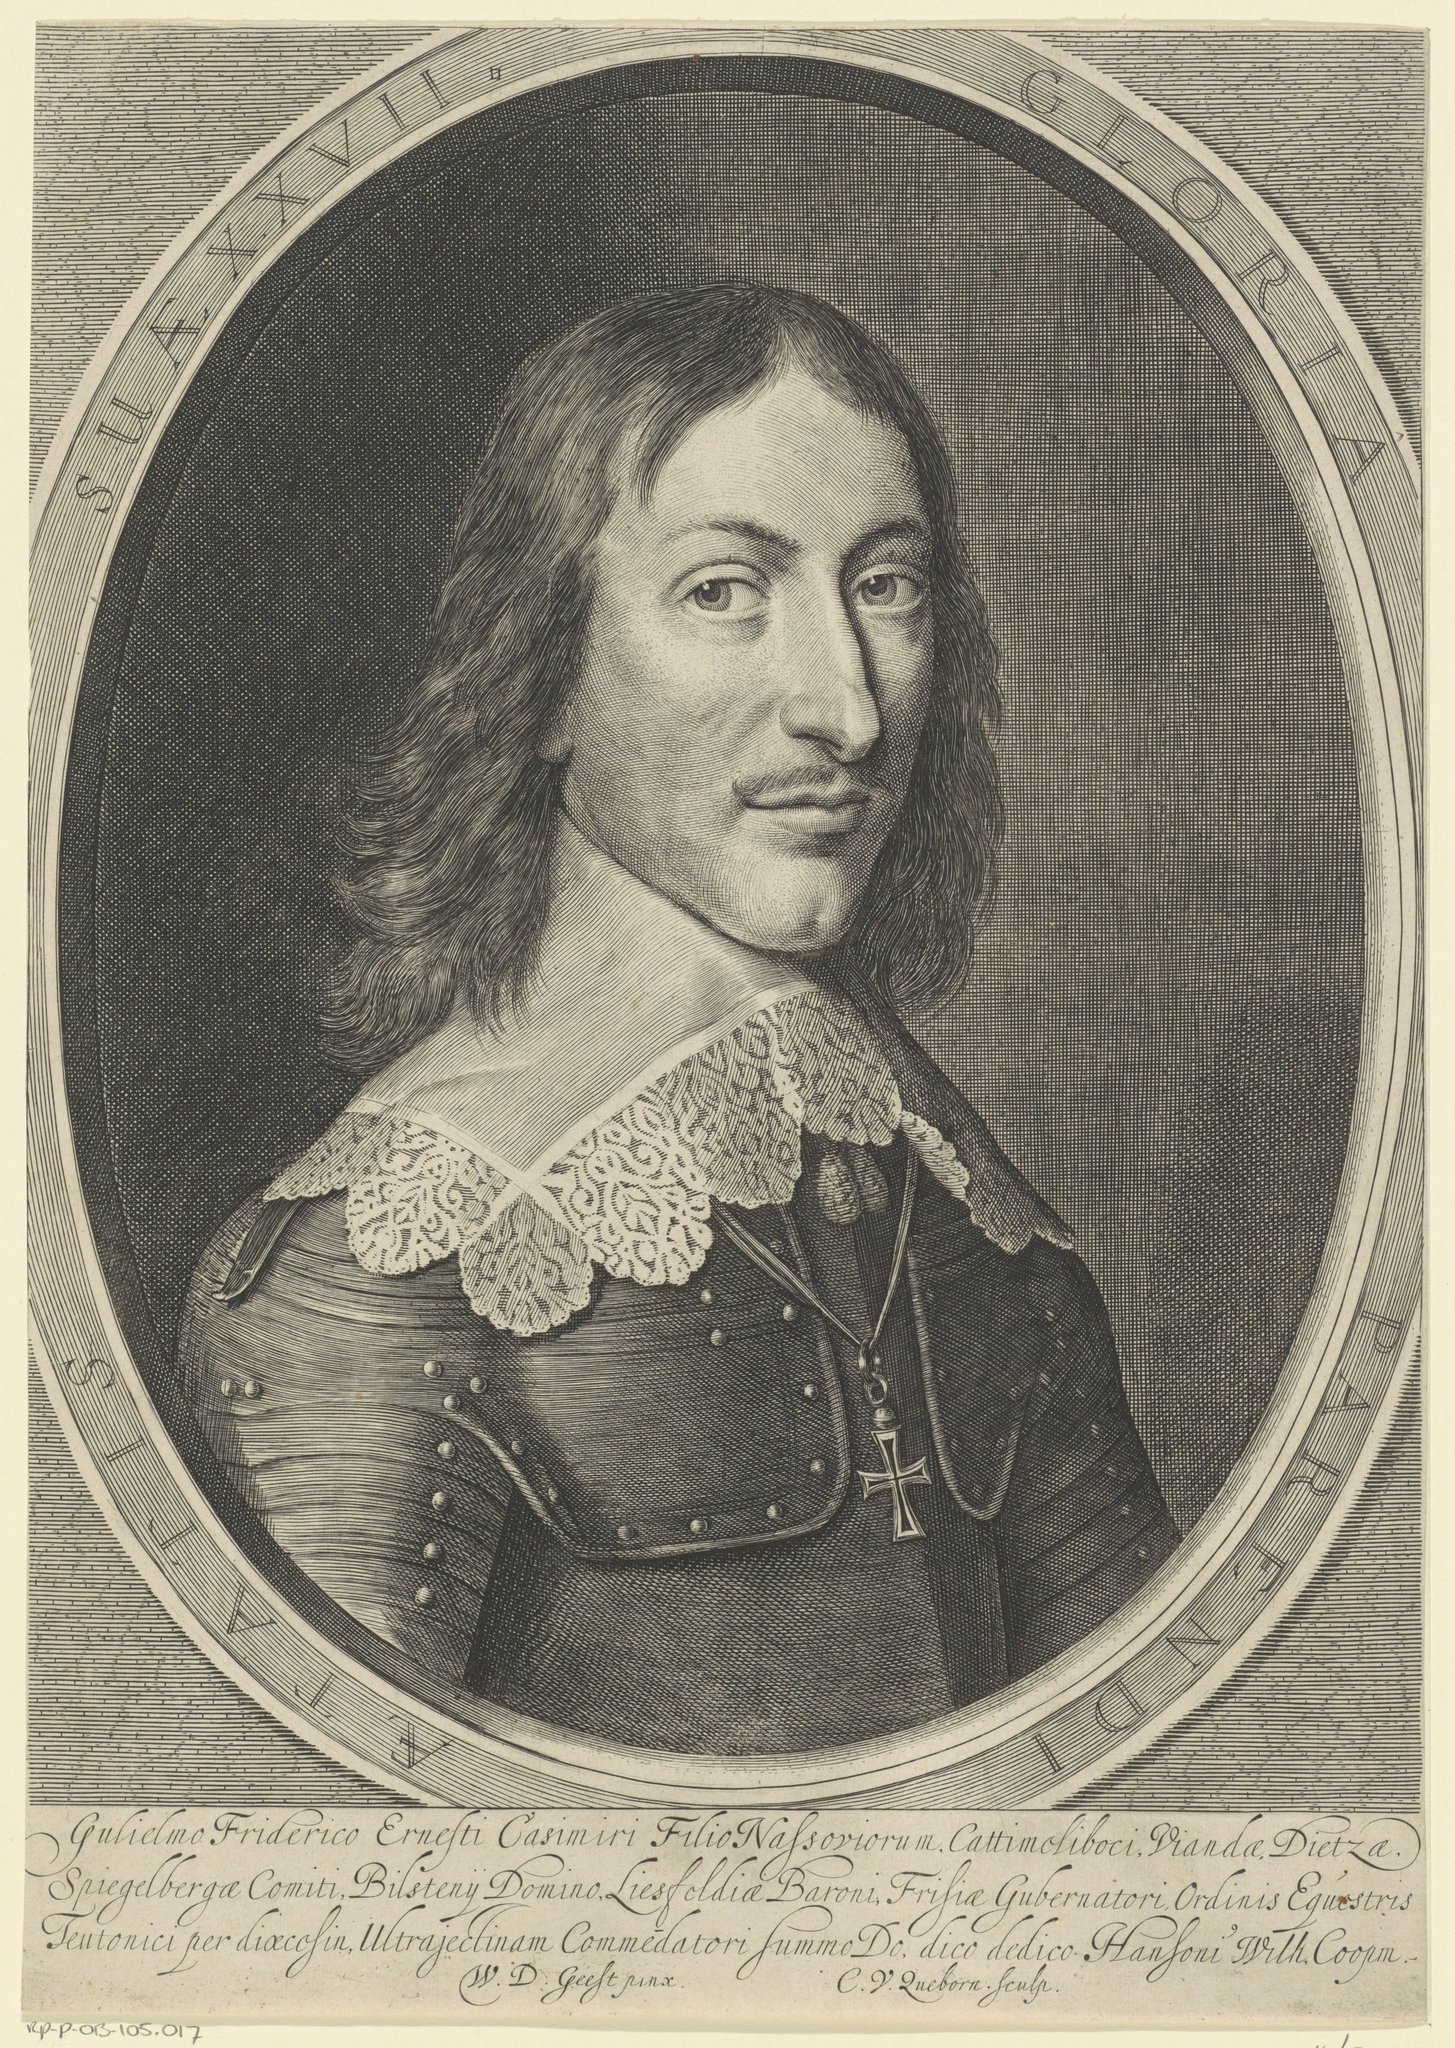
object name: print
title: Portret van Willem Frederik, graaf van Nassau-Dietz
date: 1640-1645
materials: paper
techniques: engraving, etching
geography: the hague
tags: arnhem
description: De hier vermelde titel verwijst naar de hoogst verkregen titel van de geportretteerde, niet per se naar de titel die de geportretteerde op deze voorstelling draagt.